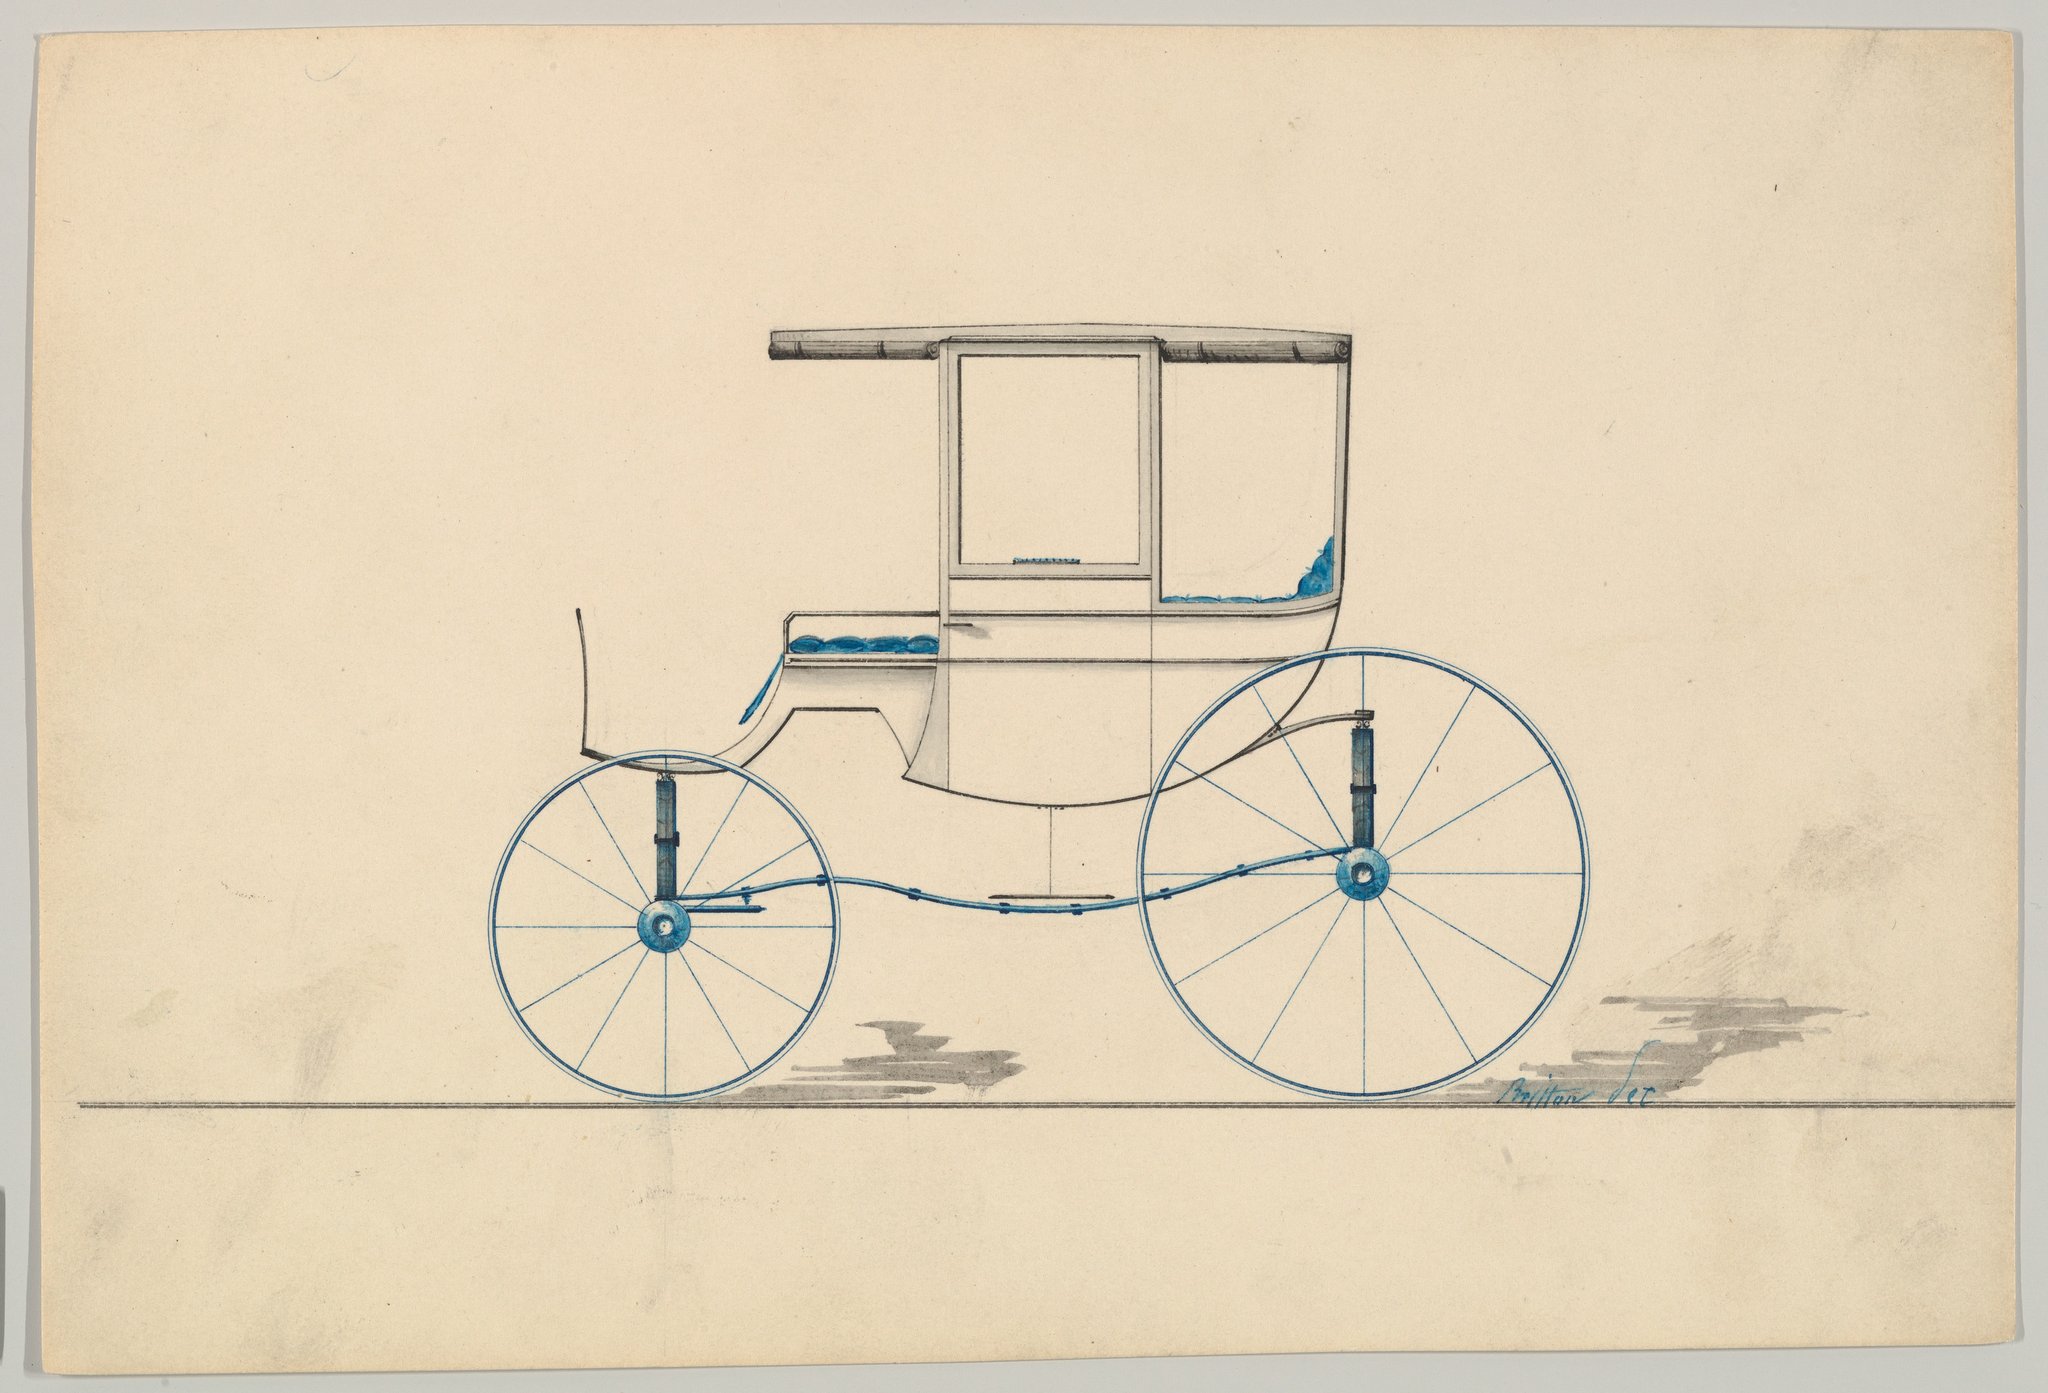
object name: drawing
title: Rockaway (unnumbered)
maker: brewster & co.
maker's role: manufacturer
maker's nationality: american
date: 1870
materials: ink, watercolor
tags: carriages